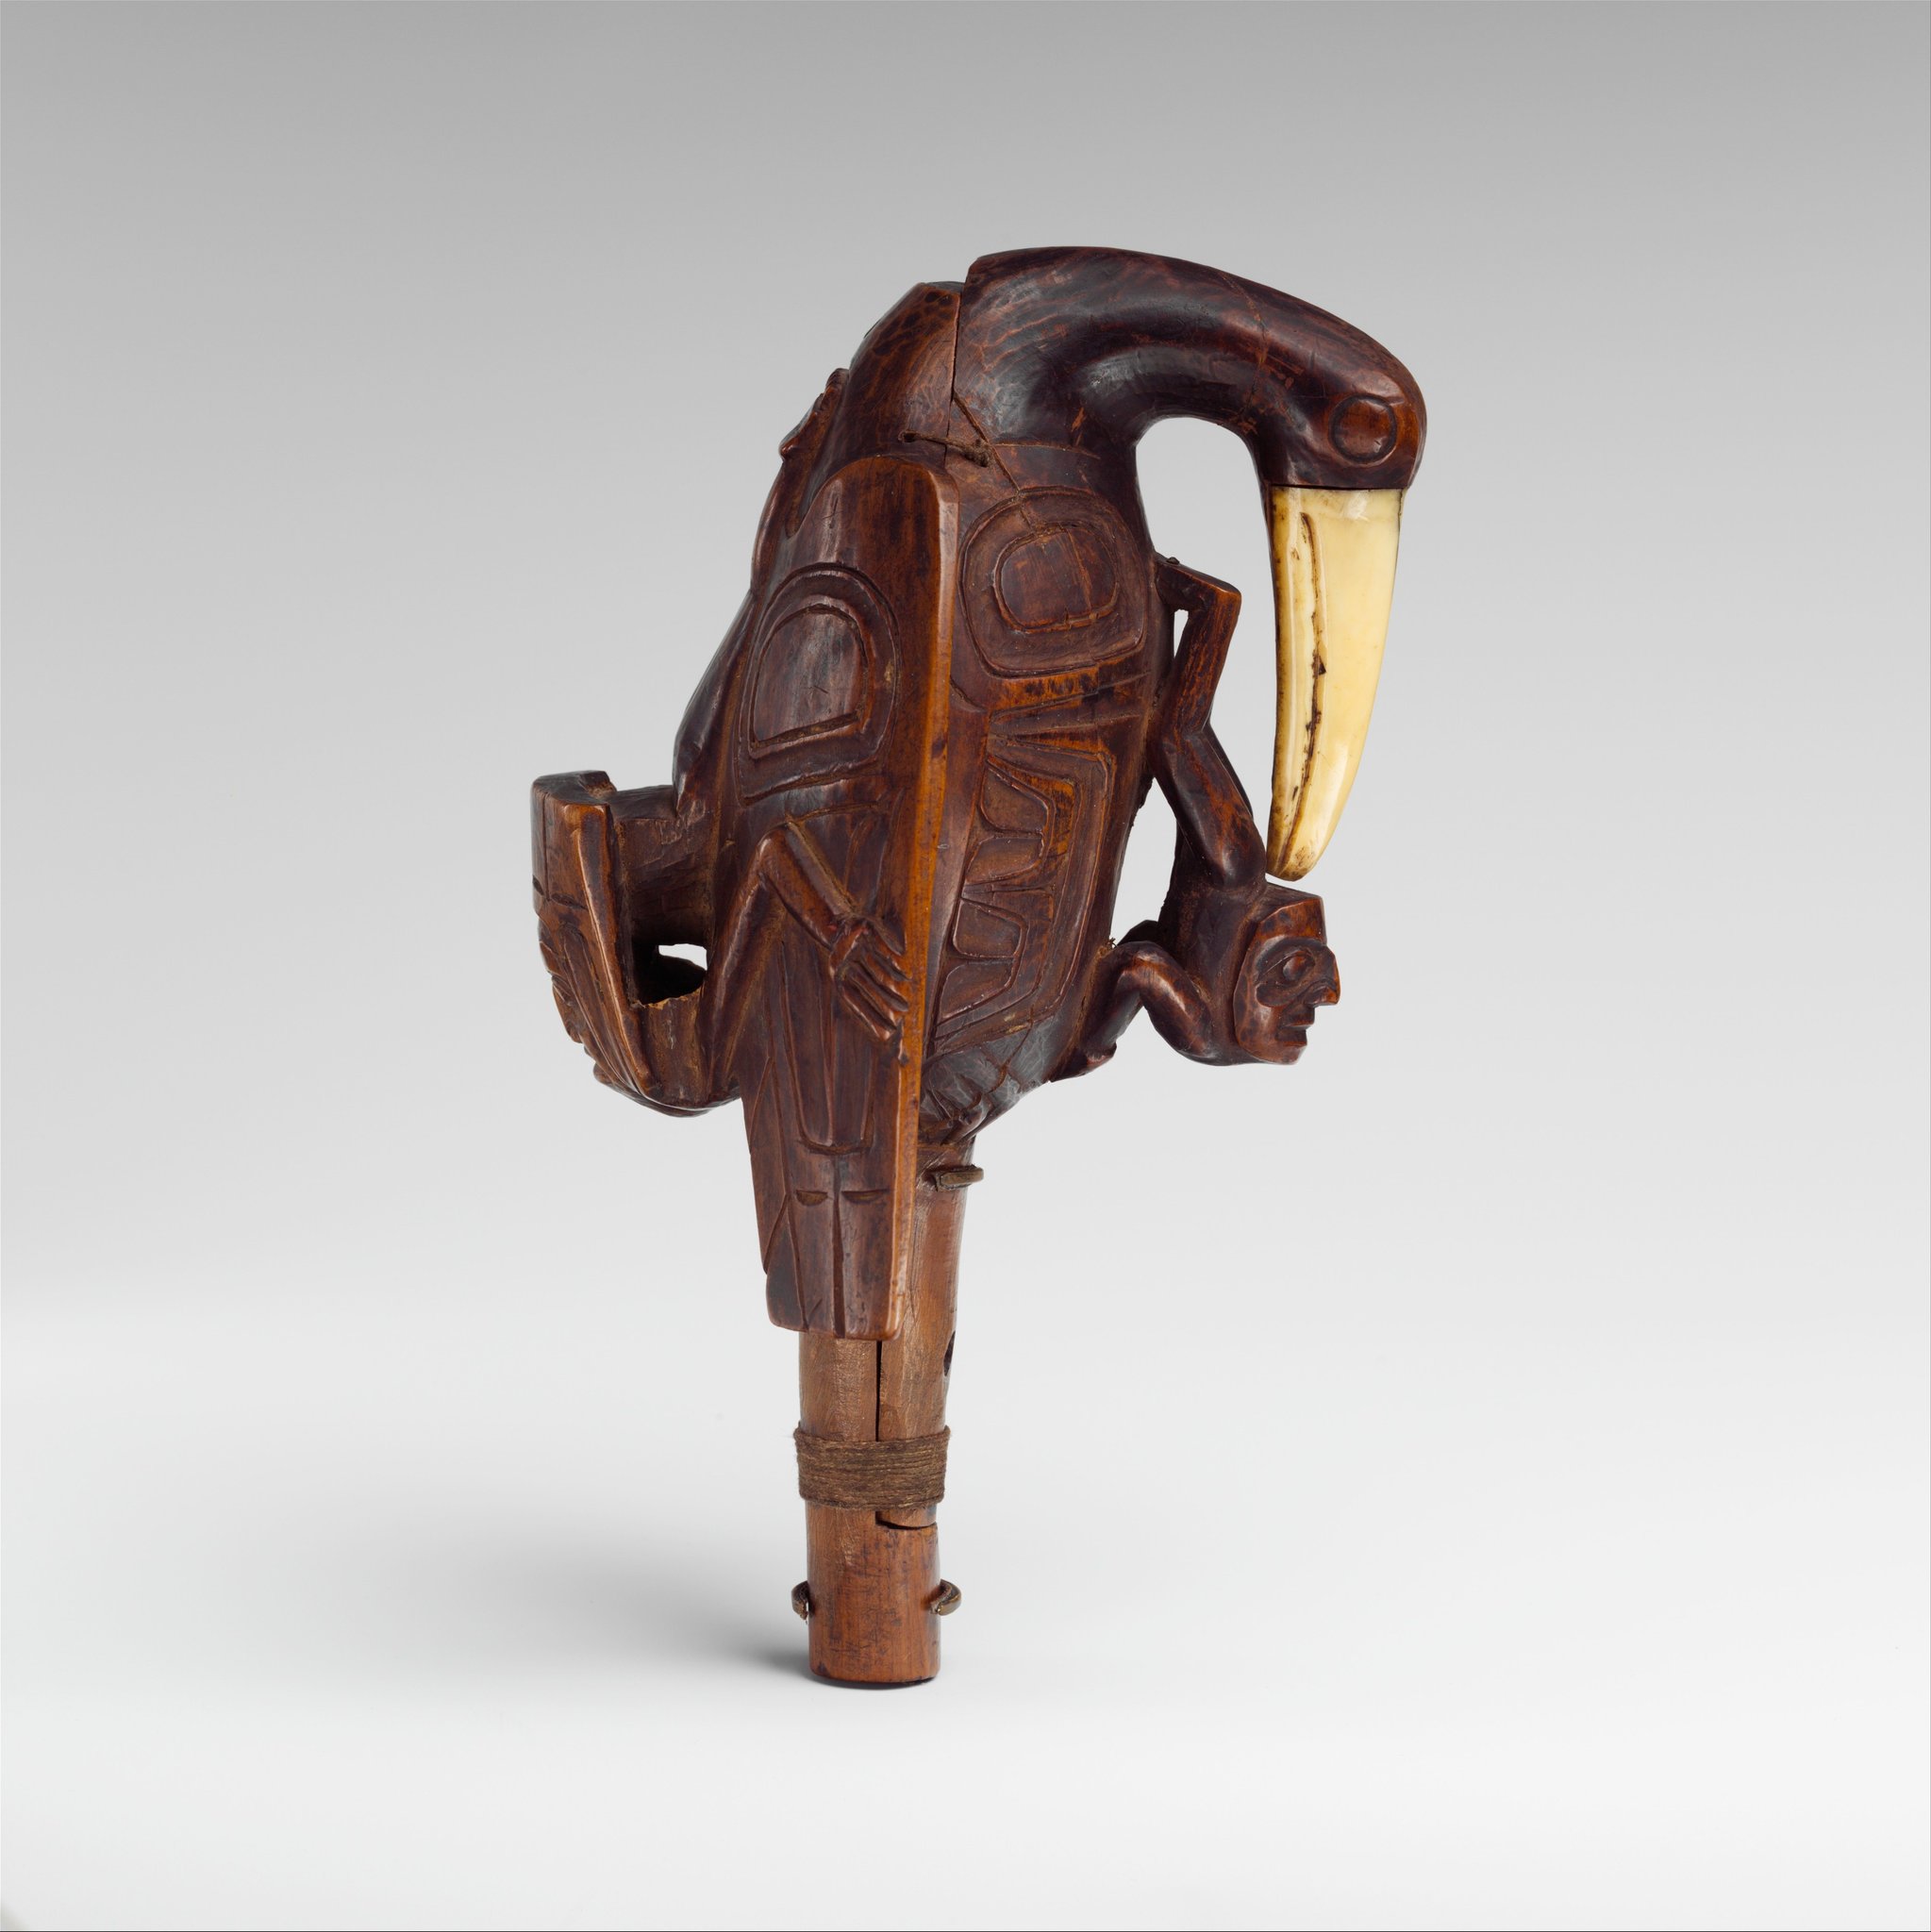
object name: rattle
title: Raven Rattle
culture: haida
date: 1840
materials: ivory, wood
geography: canada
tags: musical instruments,birds